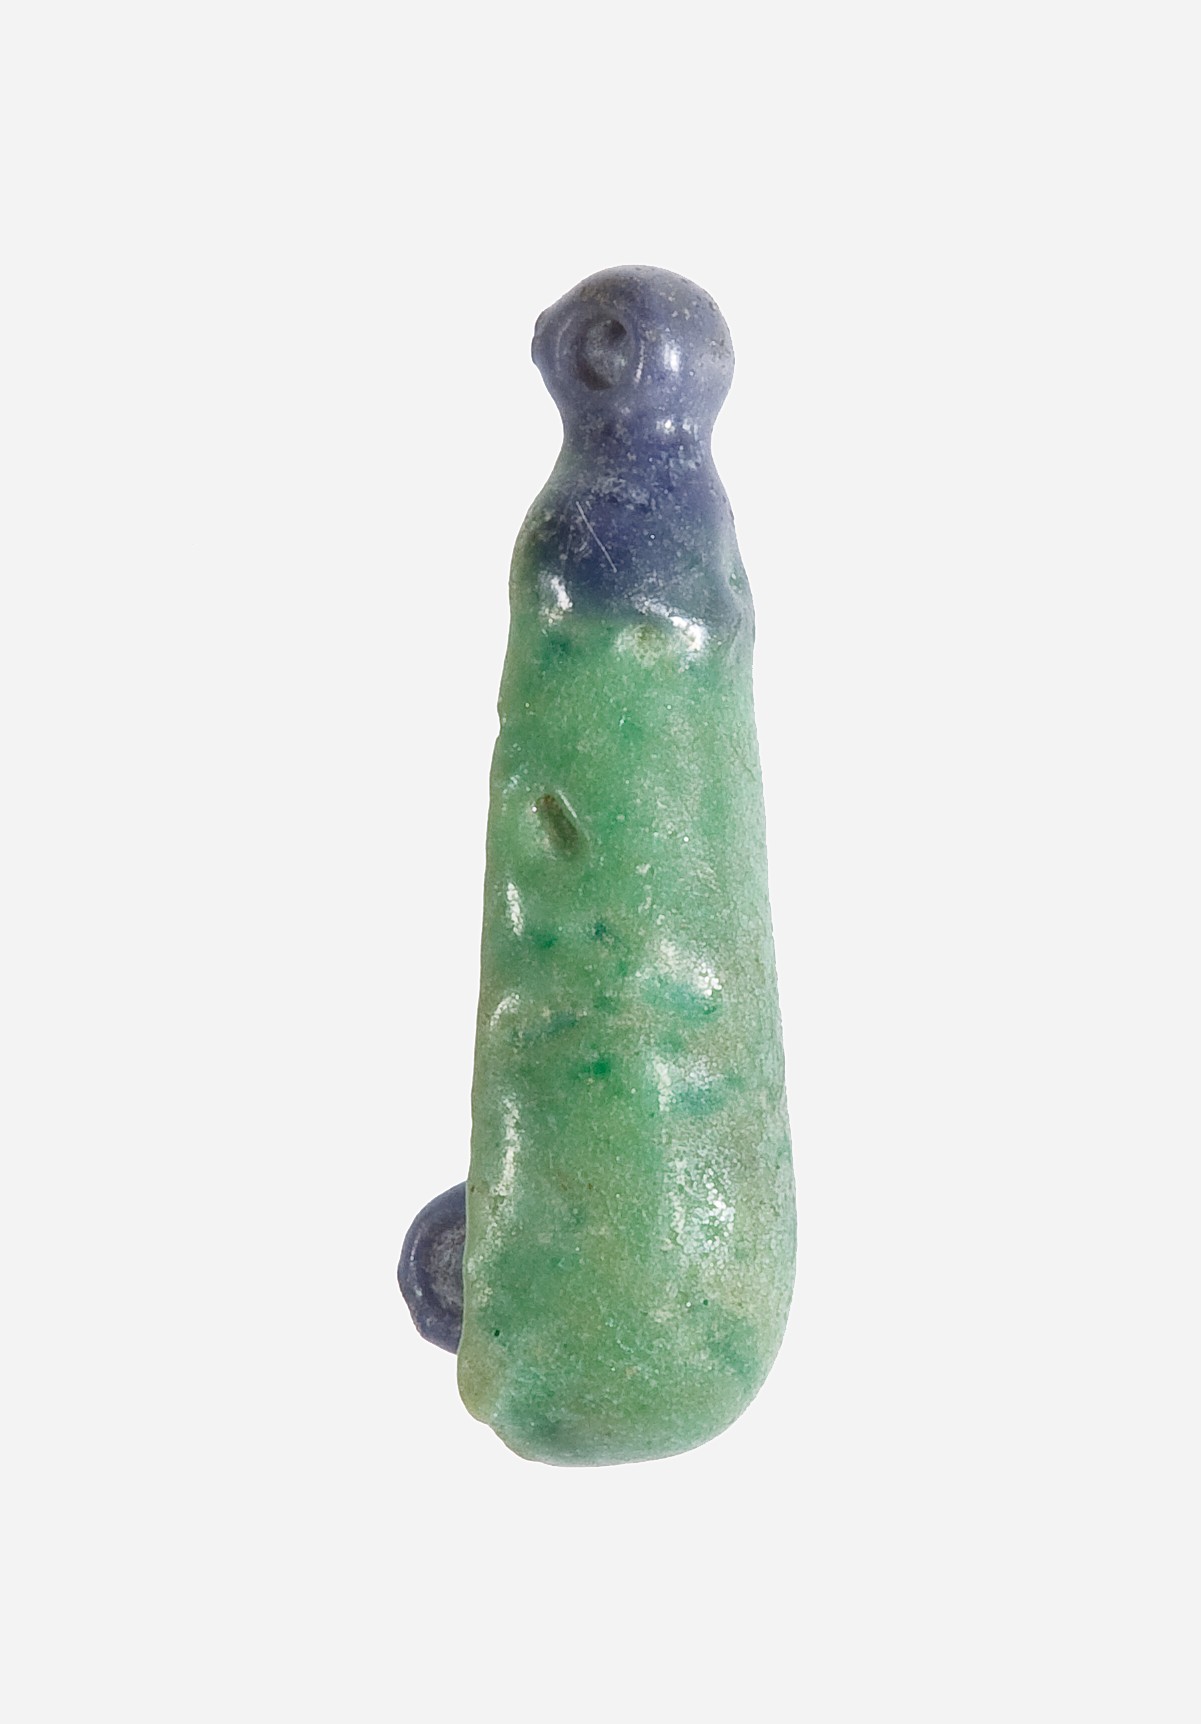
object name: pendant, date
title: Date Pendant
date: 1390-1352 BCE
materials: faience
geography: egypt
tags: fruit